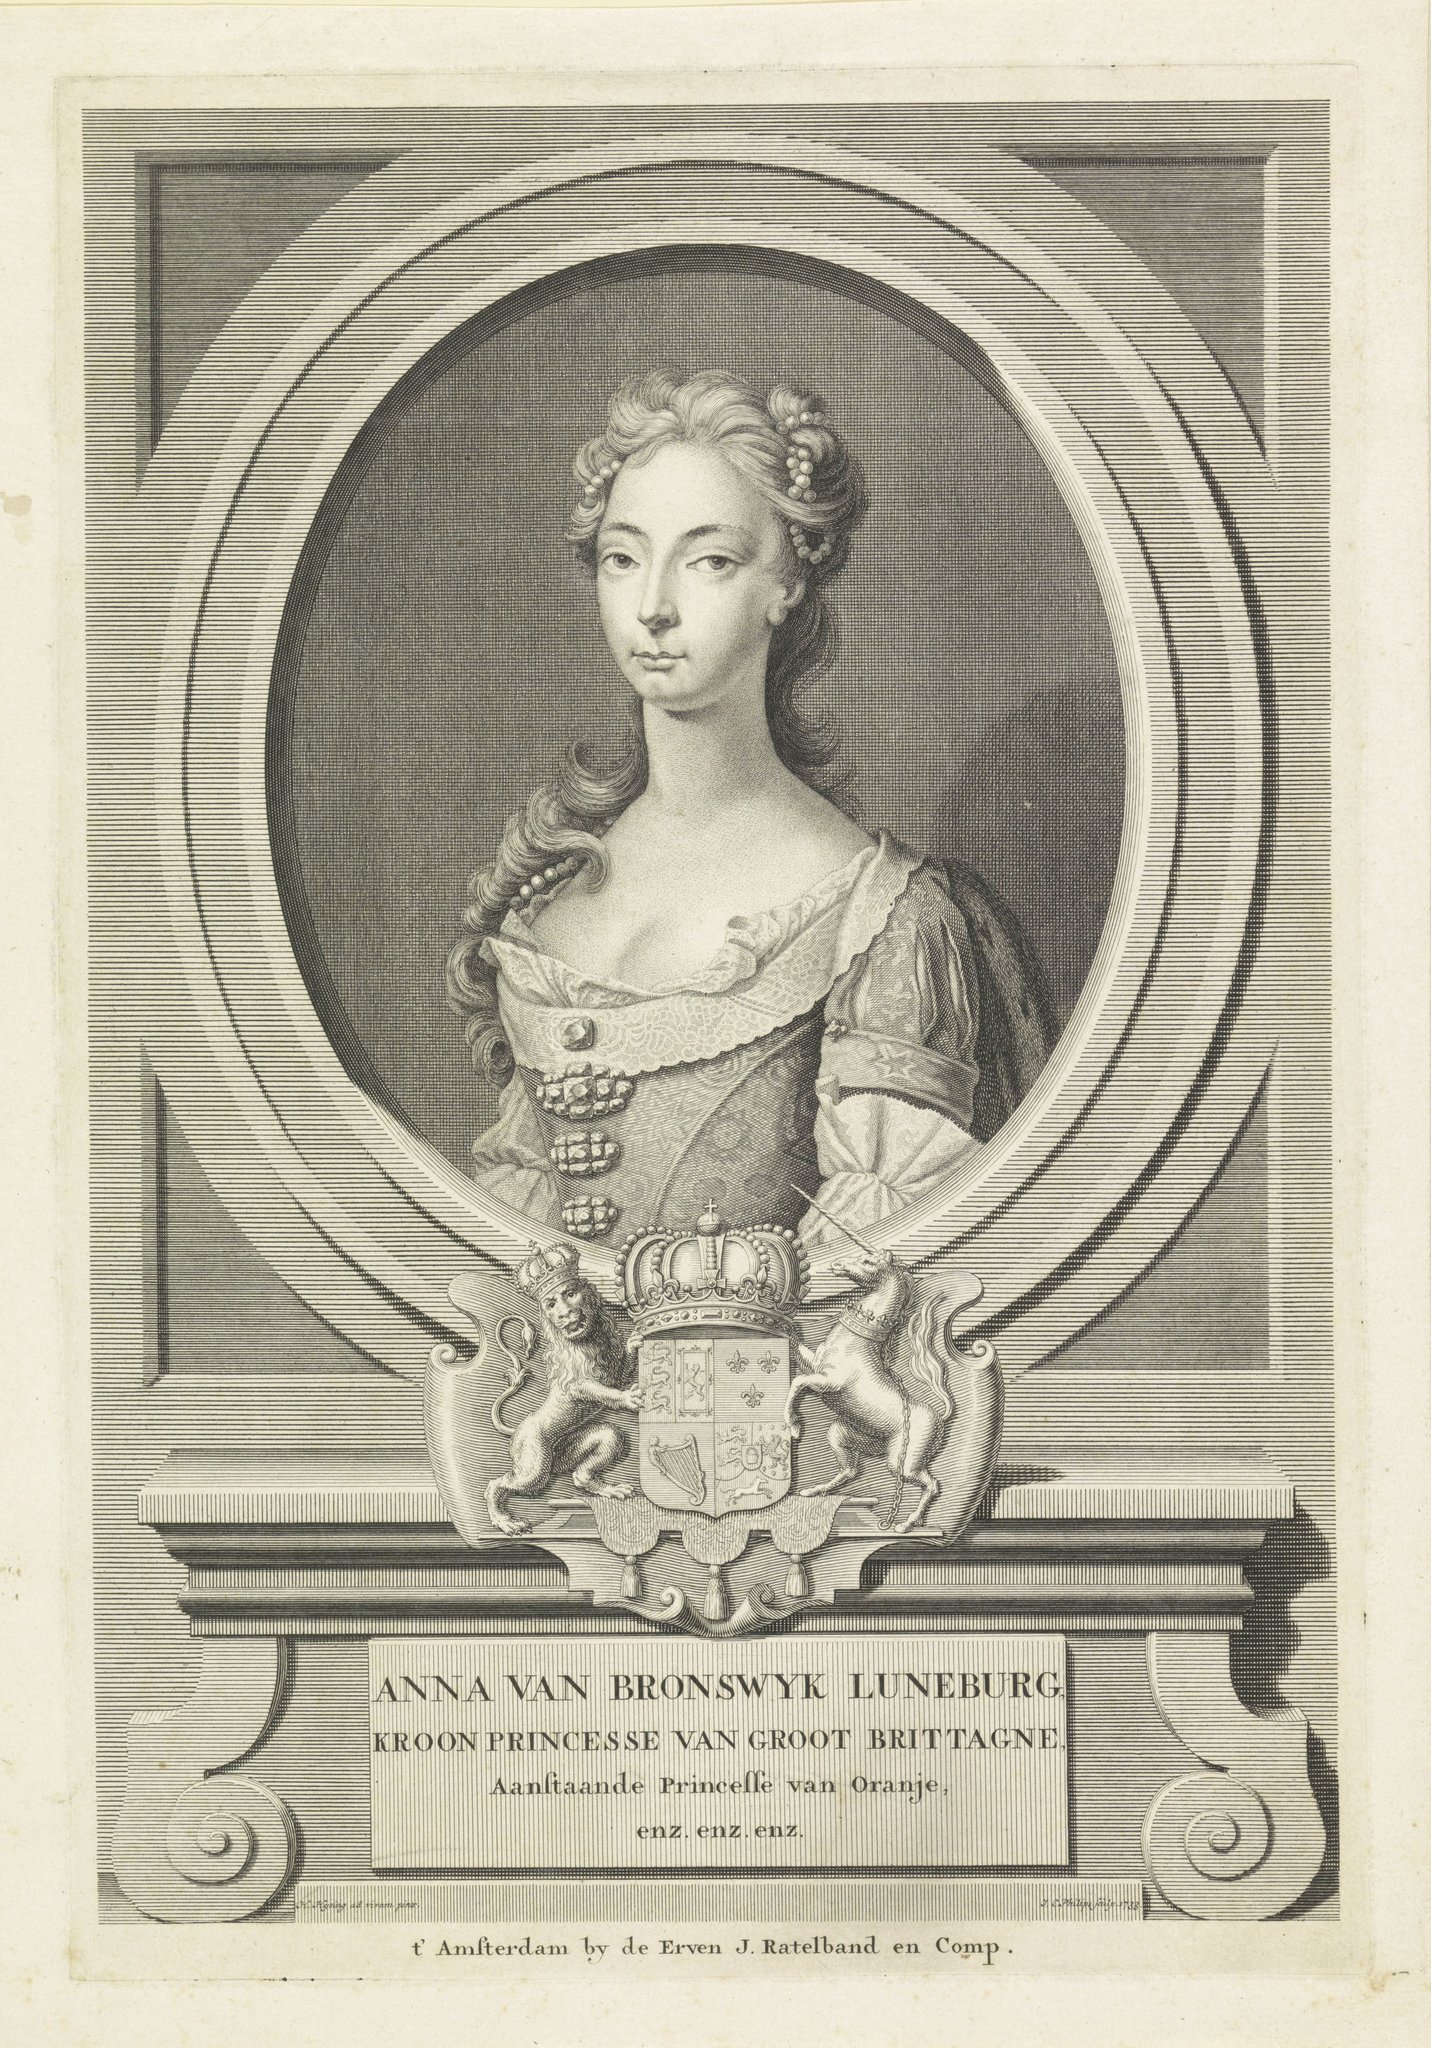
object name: print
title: Portret van Anna van Hannover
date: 1733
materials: paper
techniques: engraving, etching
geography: amsterdam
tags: anna van hannover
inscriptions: date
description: Portret van Anna in een ovaal. Midden onder haar wapen met een kroon, een leeuw en een eenhoorn. Op een voetstuk haar naam en titels.